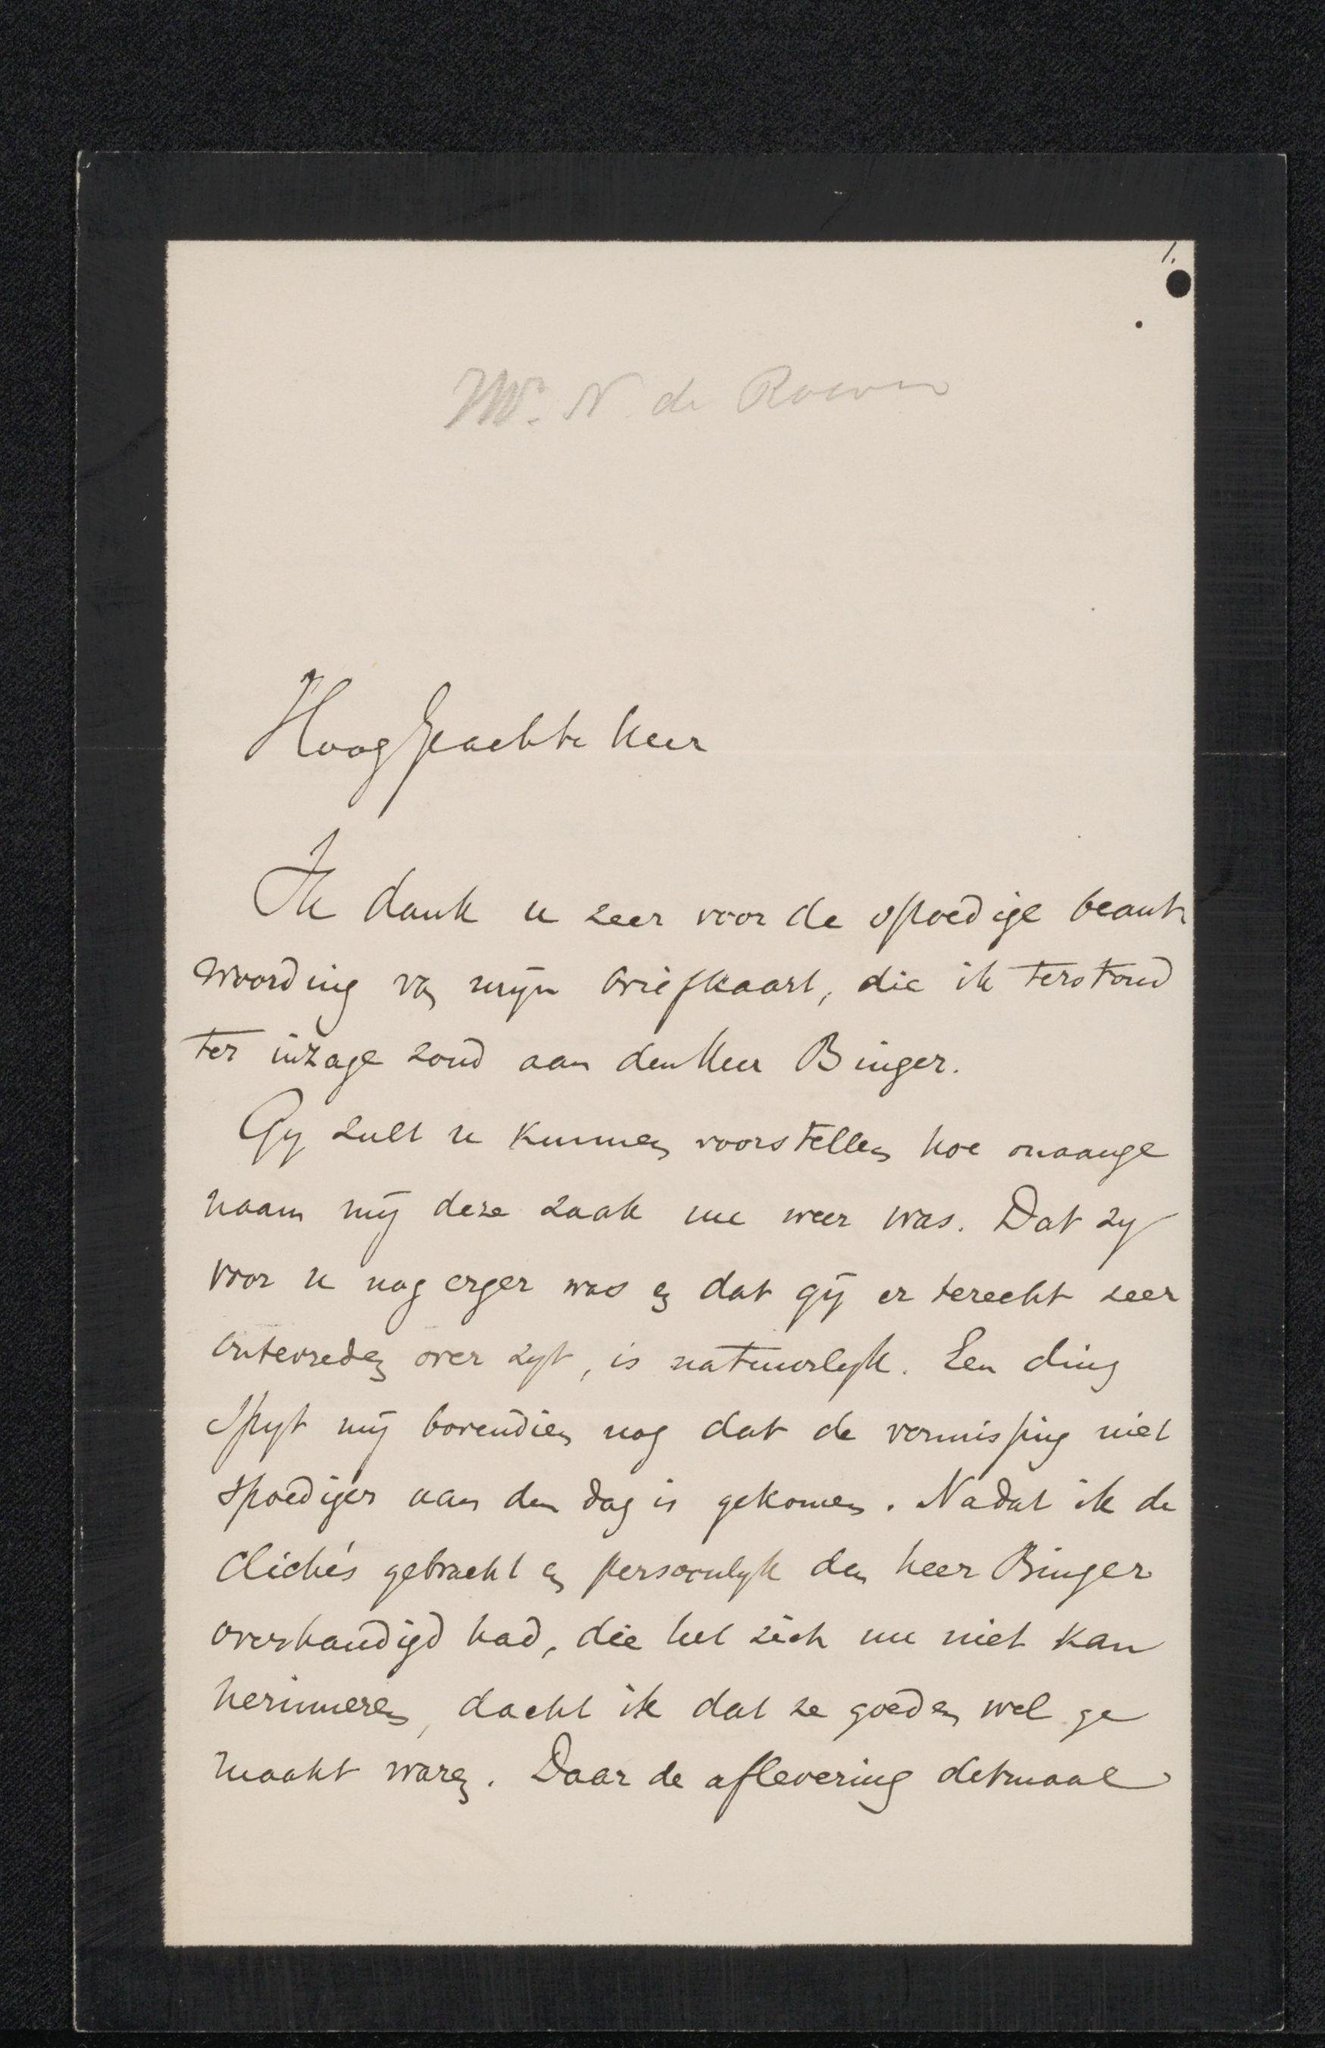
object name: letter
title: Brief aan anoniem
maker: nicolaas de roever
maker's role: draughtsman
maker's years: 1850-1894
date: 1860-1894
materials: ink, paper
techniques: pen, writing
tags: print maker, printer, charles binger, passions, emotions, affections, photography, cinematography, the graphic arts, printed matter